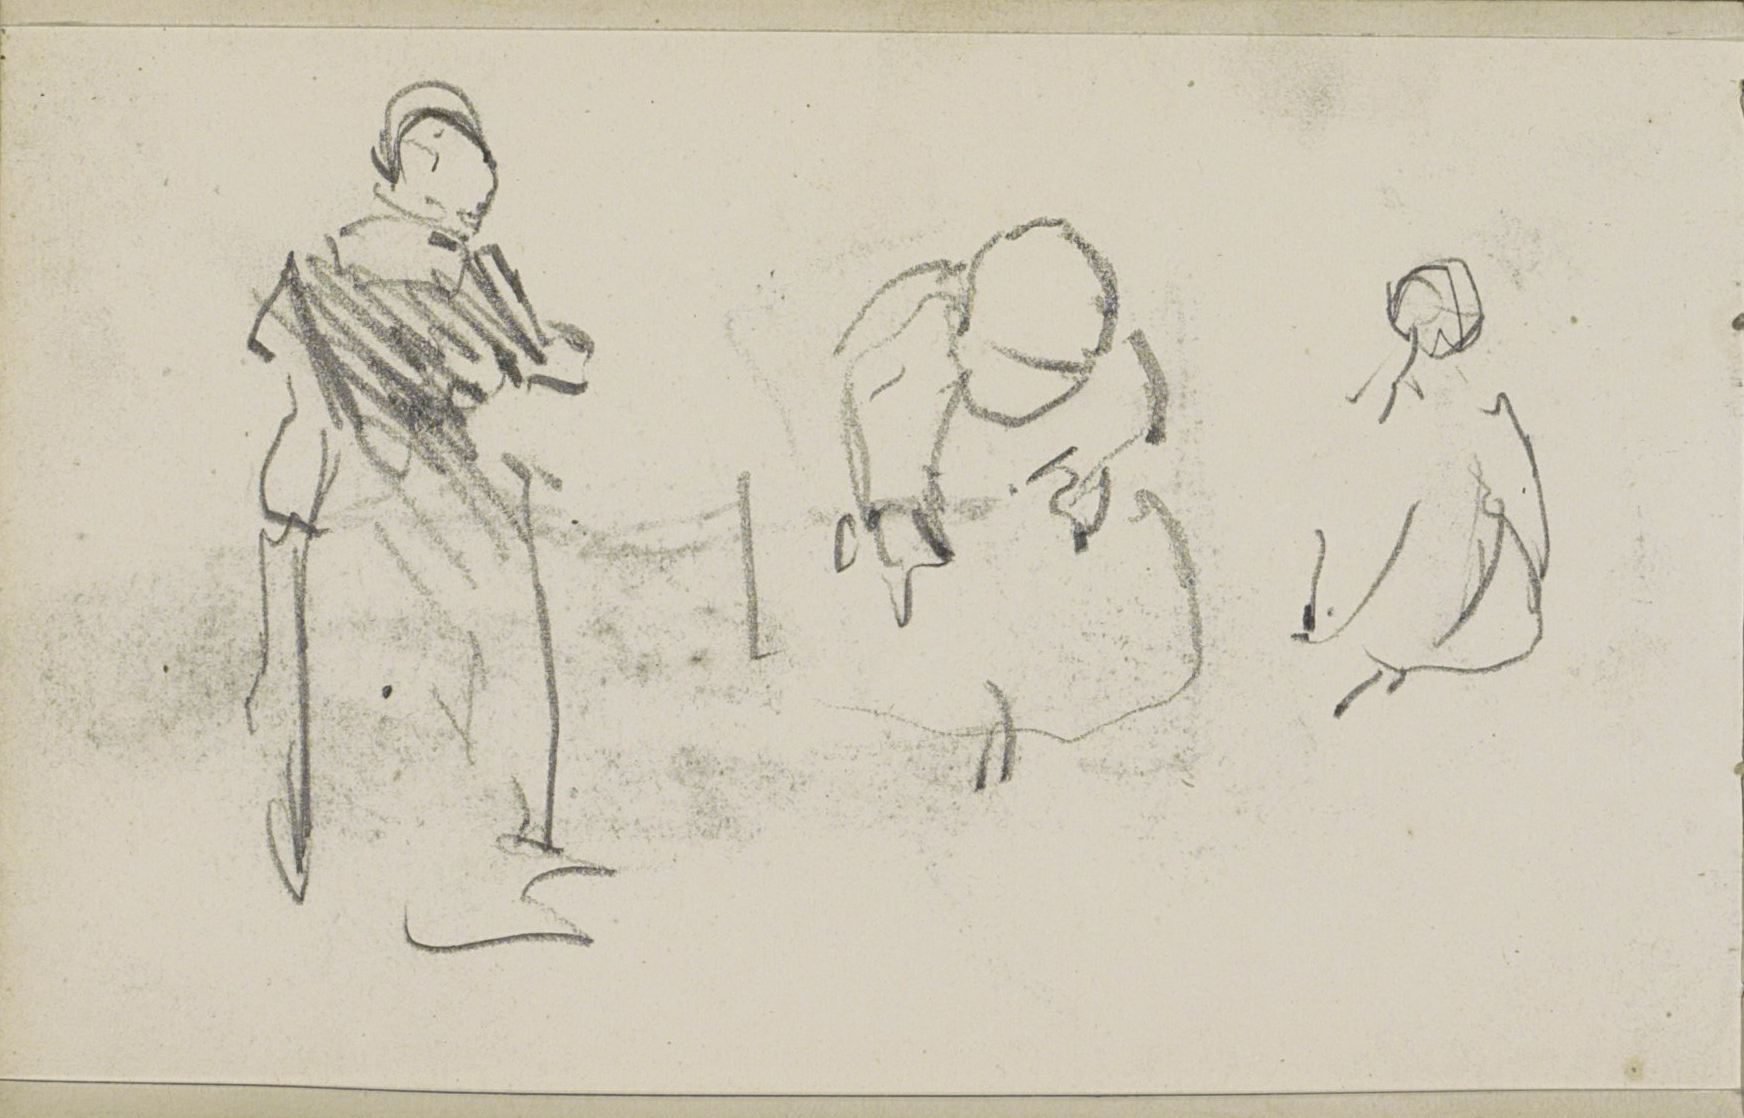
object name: sketchbook leaf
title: Drie Volendamse vrouwen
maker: george clausen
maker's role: draughtsman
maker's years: 1852-1912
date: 1875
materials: paper, pencil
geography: volendam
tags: folk costume, regional costume (+ women's clothes)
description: Blad 21 verso uit een schetsboek met 38 bladen.